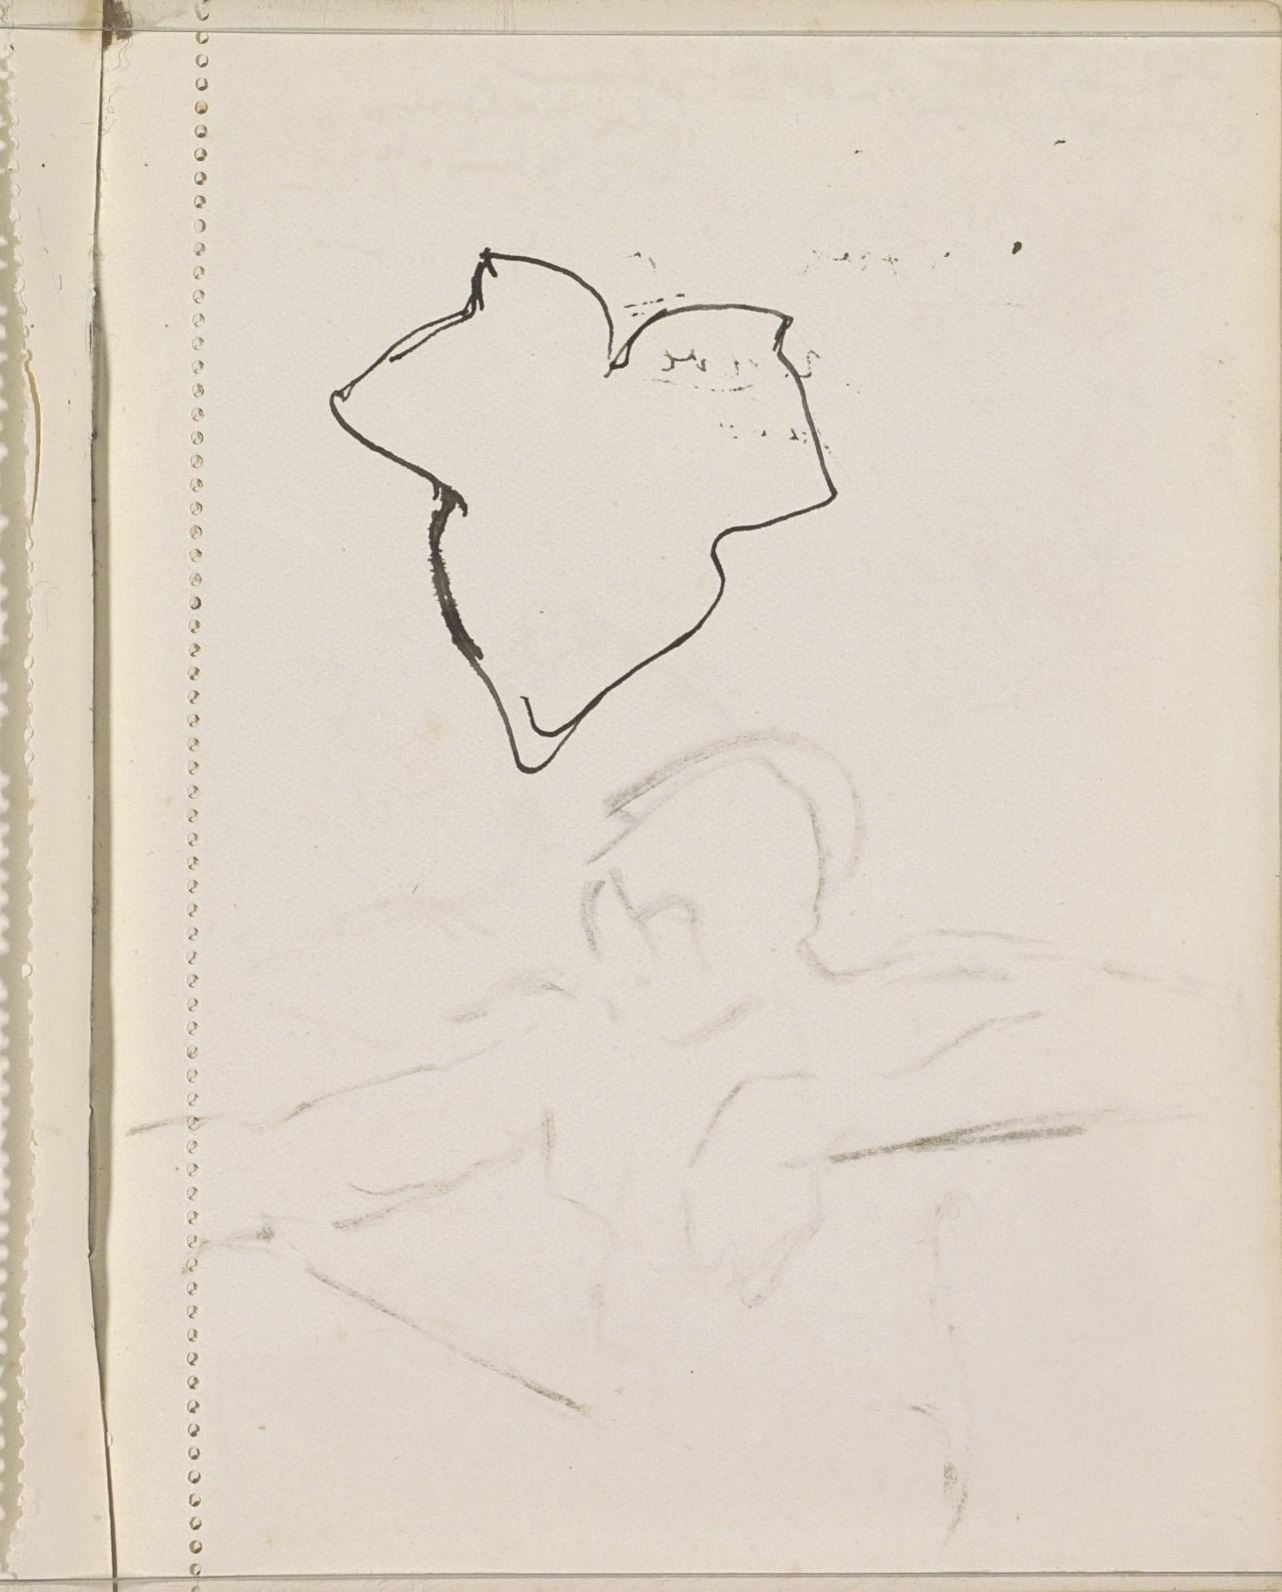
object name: sketchbook leaf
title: Blad en een zittende figuur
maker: reijer stolk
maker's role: draughtsman, print maker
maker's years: 1896-1945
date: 1906-1945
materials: ink, paper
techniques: pen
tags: trees (+ leaf), sitting figure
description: Blad 42 recto uit een schetsboek met 42 bladen.